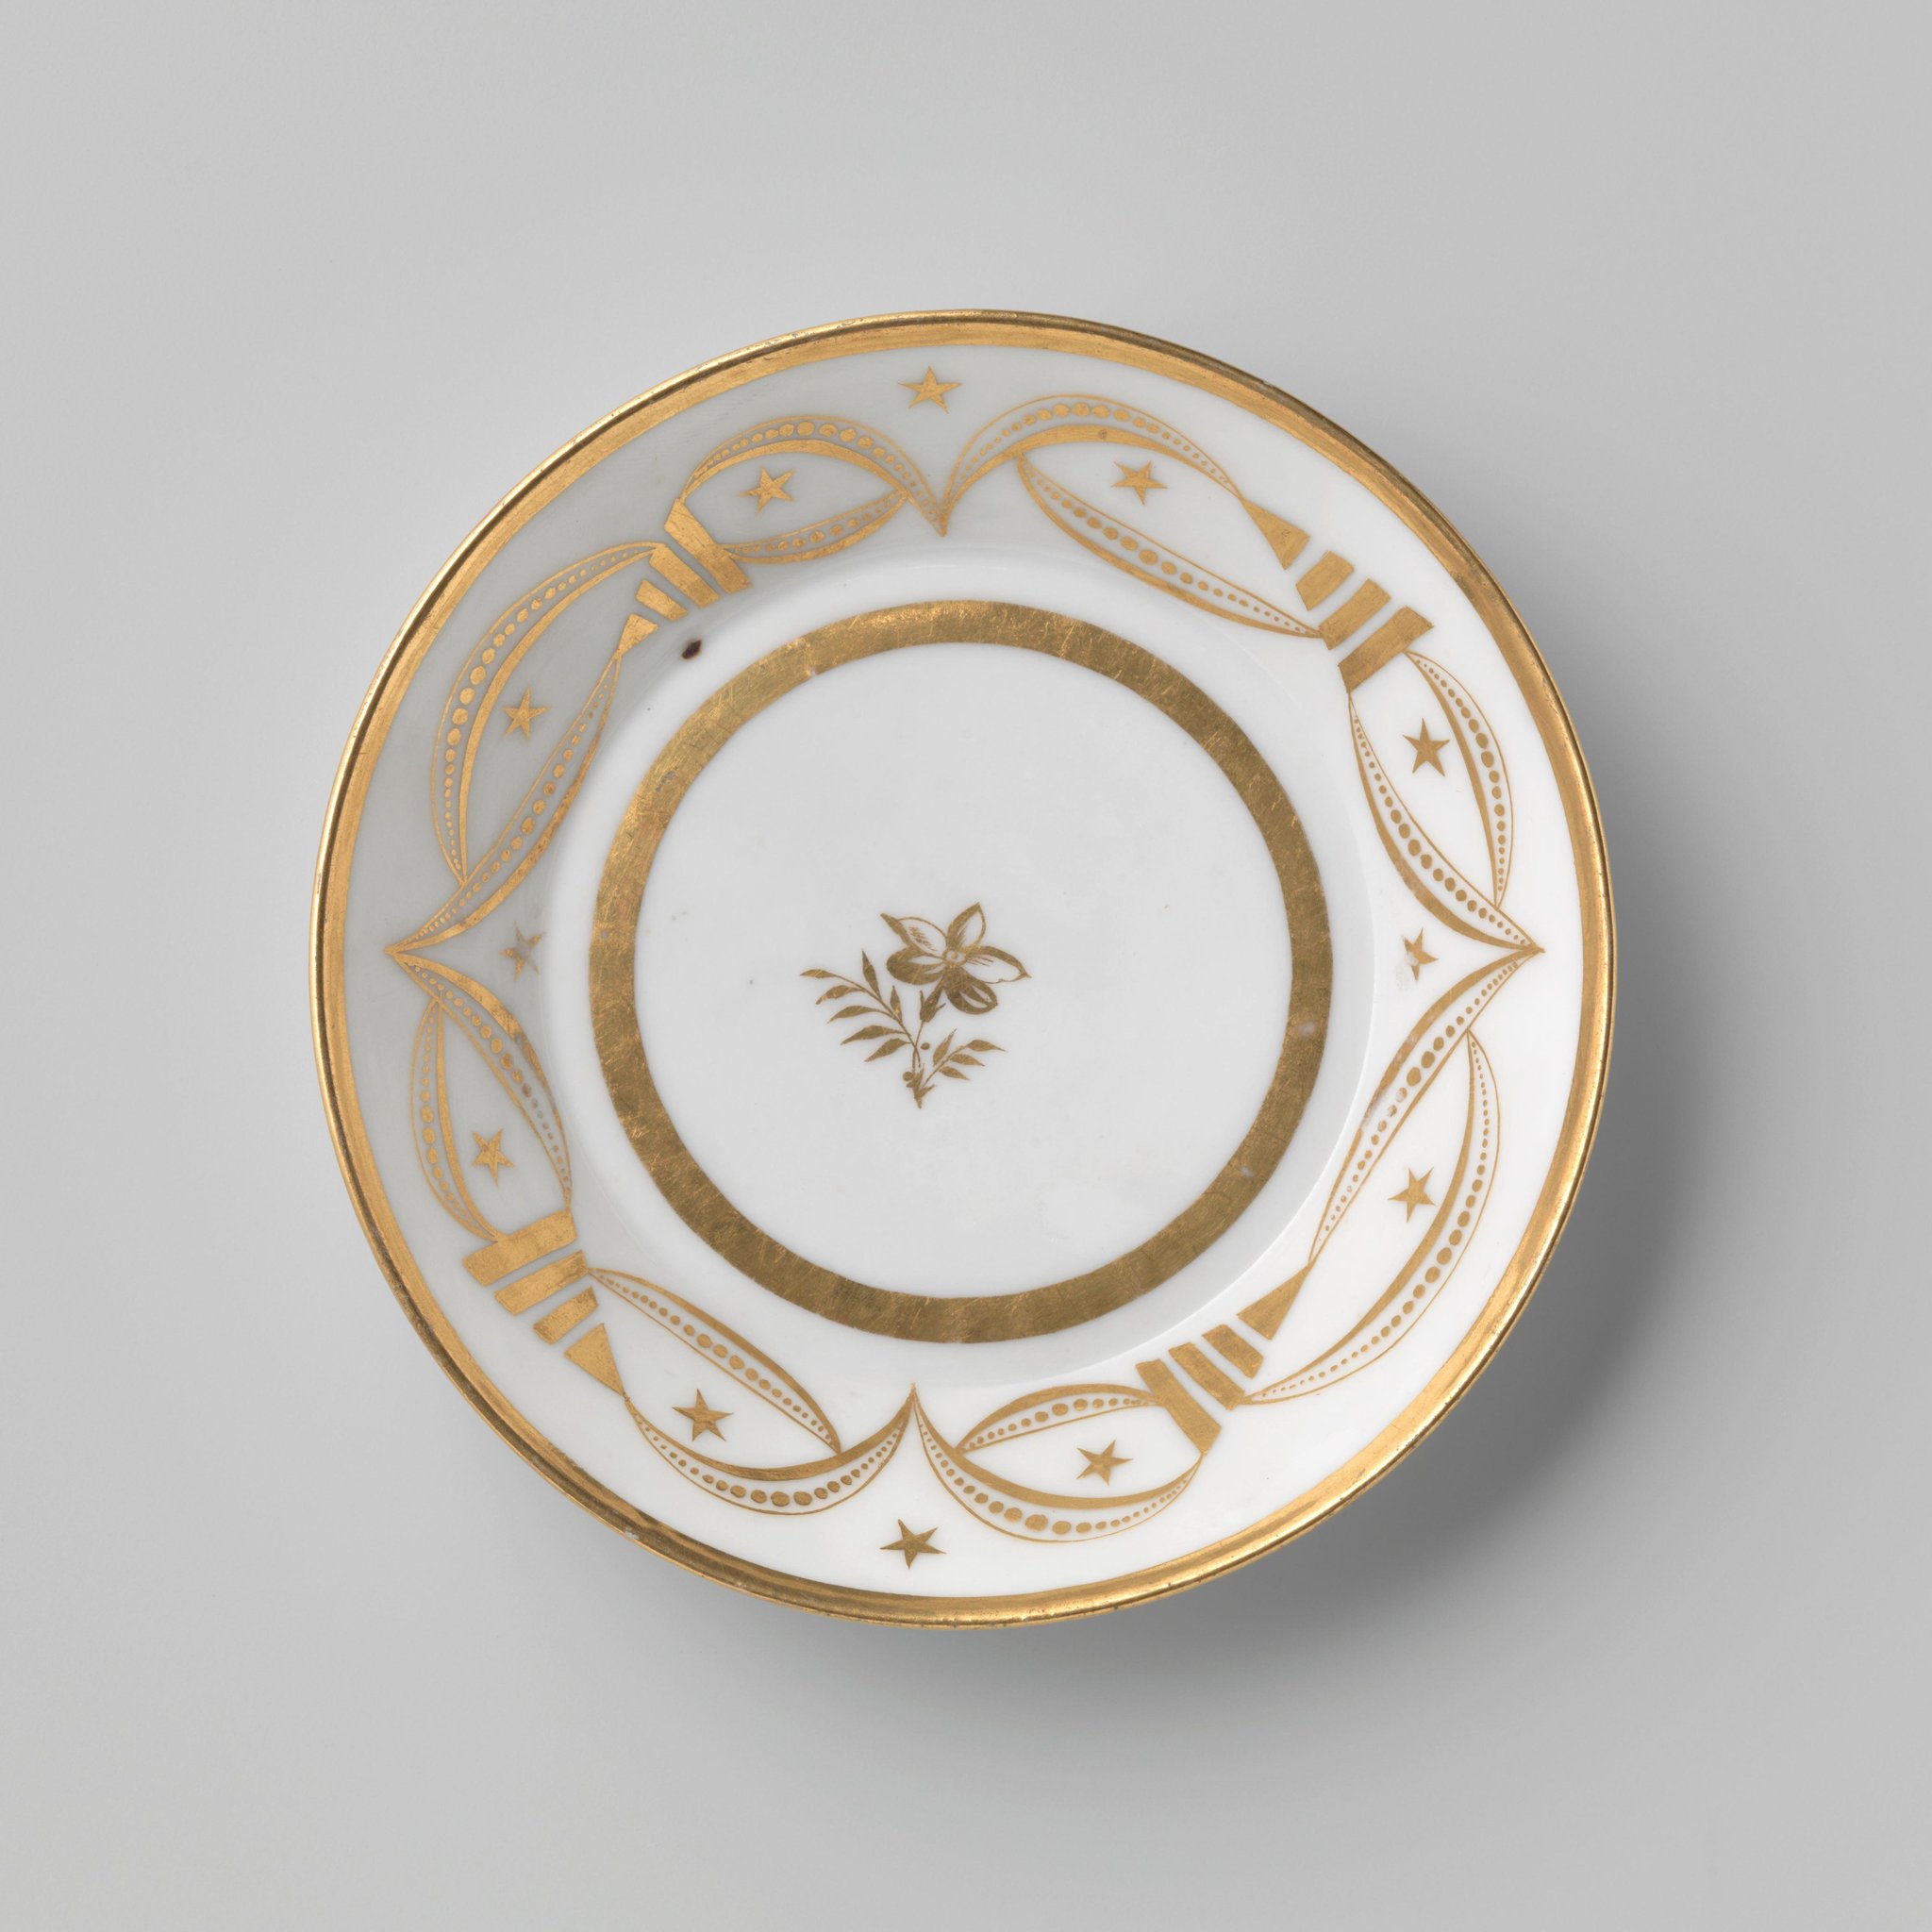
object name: service set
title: Saucer with an ornamental border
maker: Anonymous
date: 1800-1824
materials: glaze, gold, paint, porcelain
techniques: firing, forming, gilding, turning, vitrification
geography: france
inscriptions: mark: ‘g’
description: Schotel van porselein, versierd met gouden banden waartussen een slingermotief dat wordt gevormd door halvemaanvormige schijven waarin punten. De schijven worden verbonden door driehoeken. Op de tussenliggende velden gouden sterren. Op het plat een bloemtak. Behoort tot een serie van twaalf kop-en-schotels (BK-16044-F-1-24), onderdeel van een koffie- en theeservies.